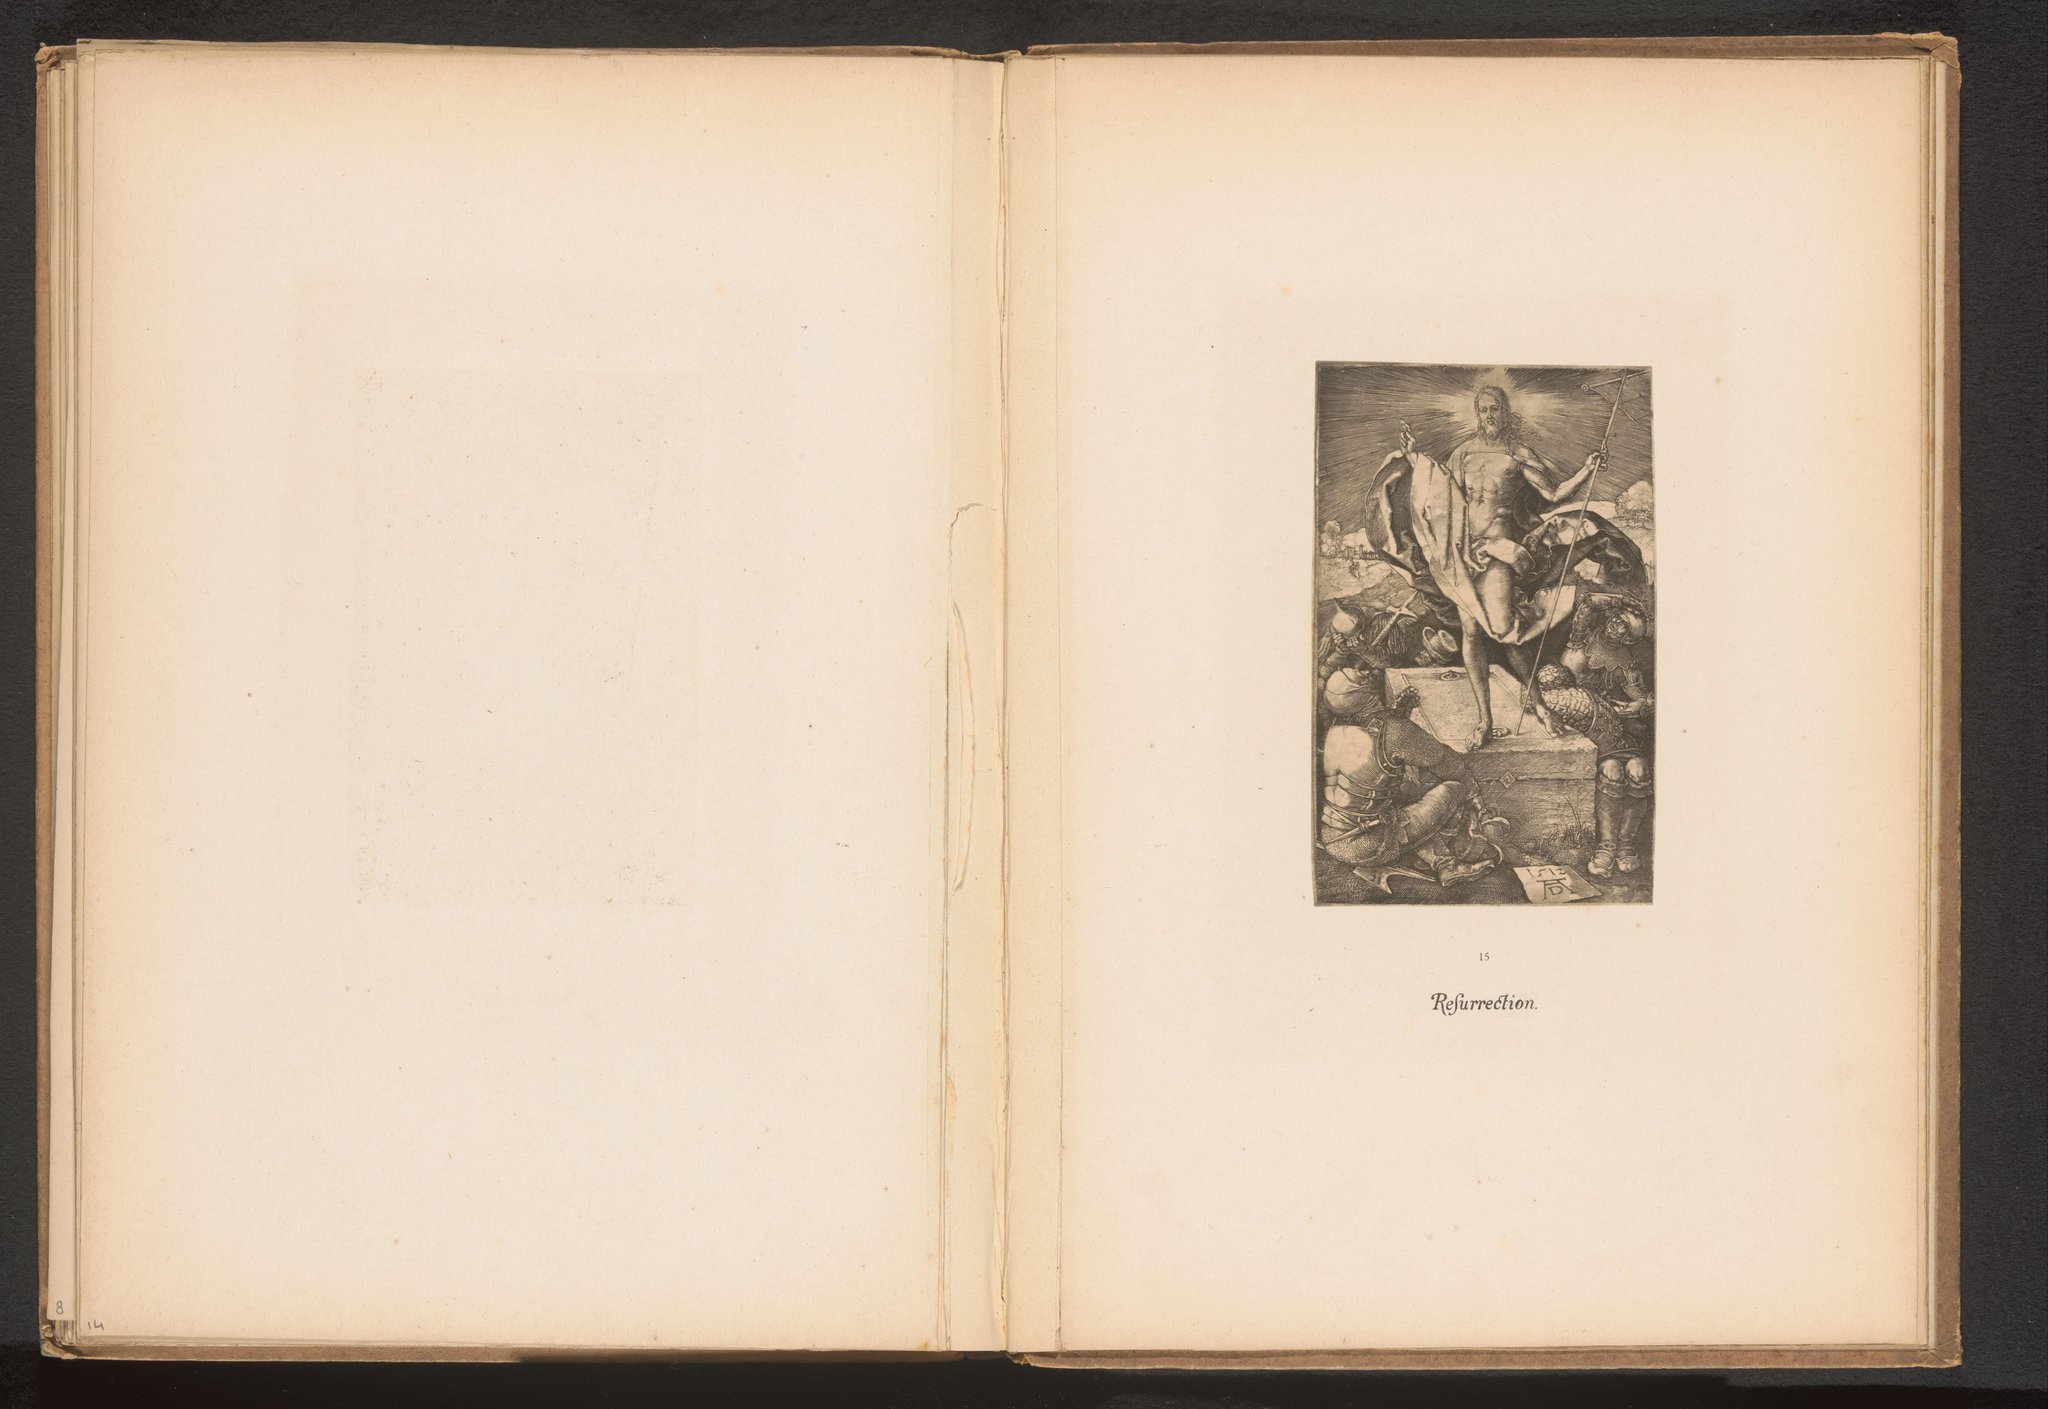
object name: reproduction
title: Reproductie van De opstanding door Albrecht Dürer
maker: albrecht dürer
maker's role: draughtsman, painter, print maker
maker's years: 1471-1528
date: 1866-1871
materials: paper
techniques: woodburytype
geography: brussels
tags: christ, usually holding a banner, arises from the grave; often combined with sleeping and/or frightened soldiers, passion of christ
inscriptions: number: ‘15’